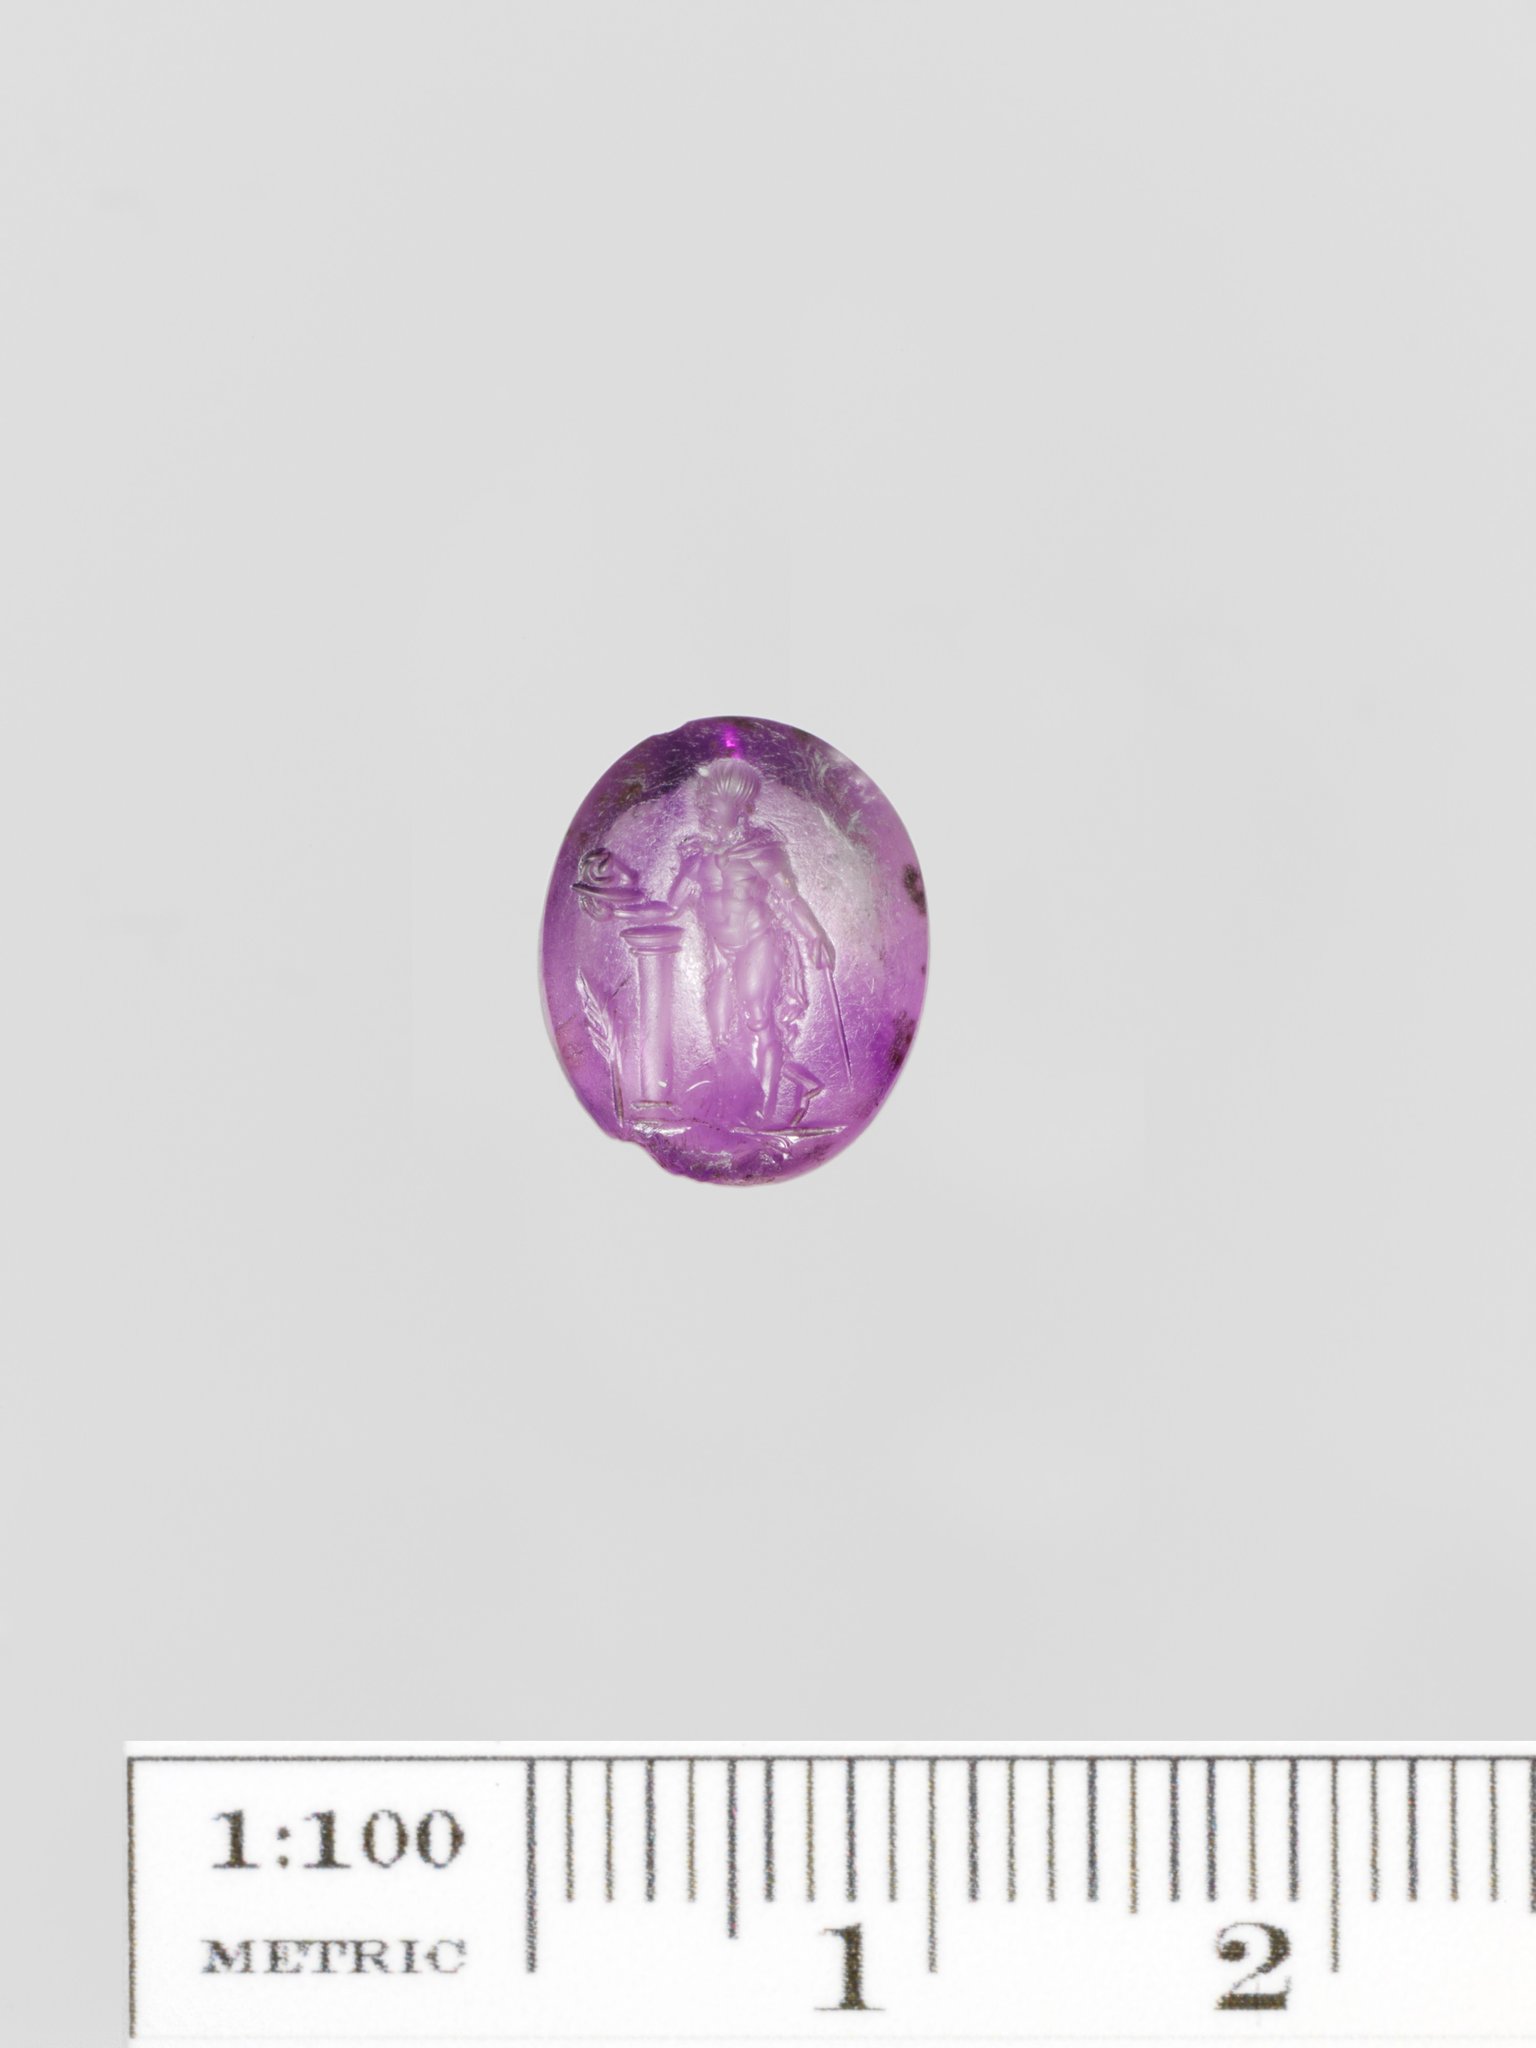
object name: intaglio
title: Amethyst ring stone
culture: roman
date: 100 BCE-300 CE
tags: hermes,rams